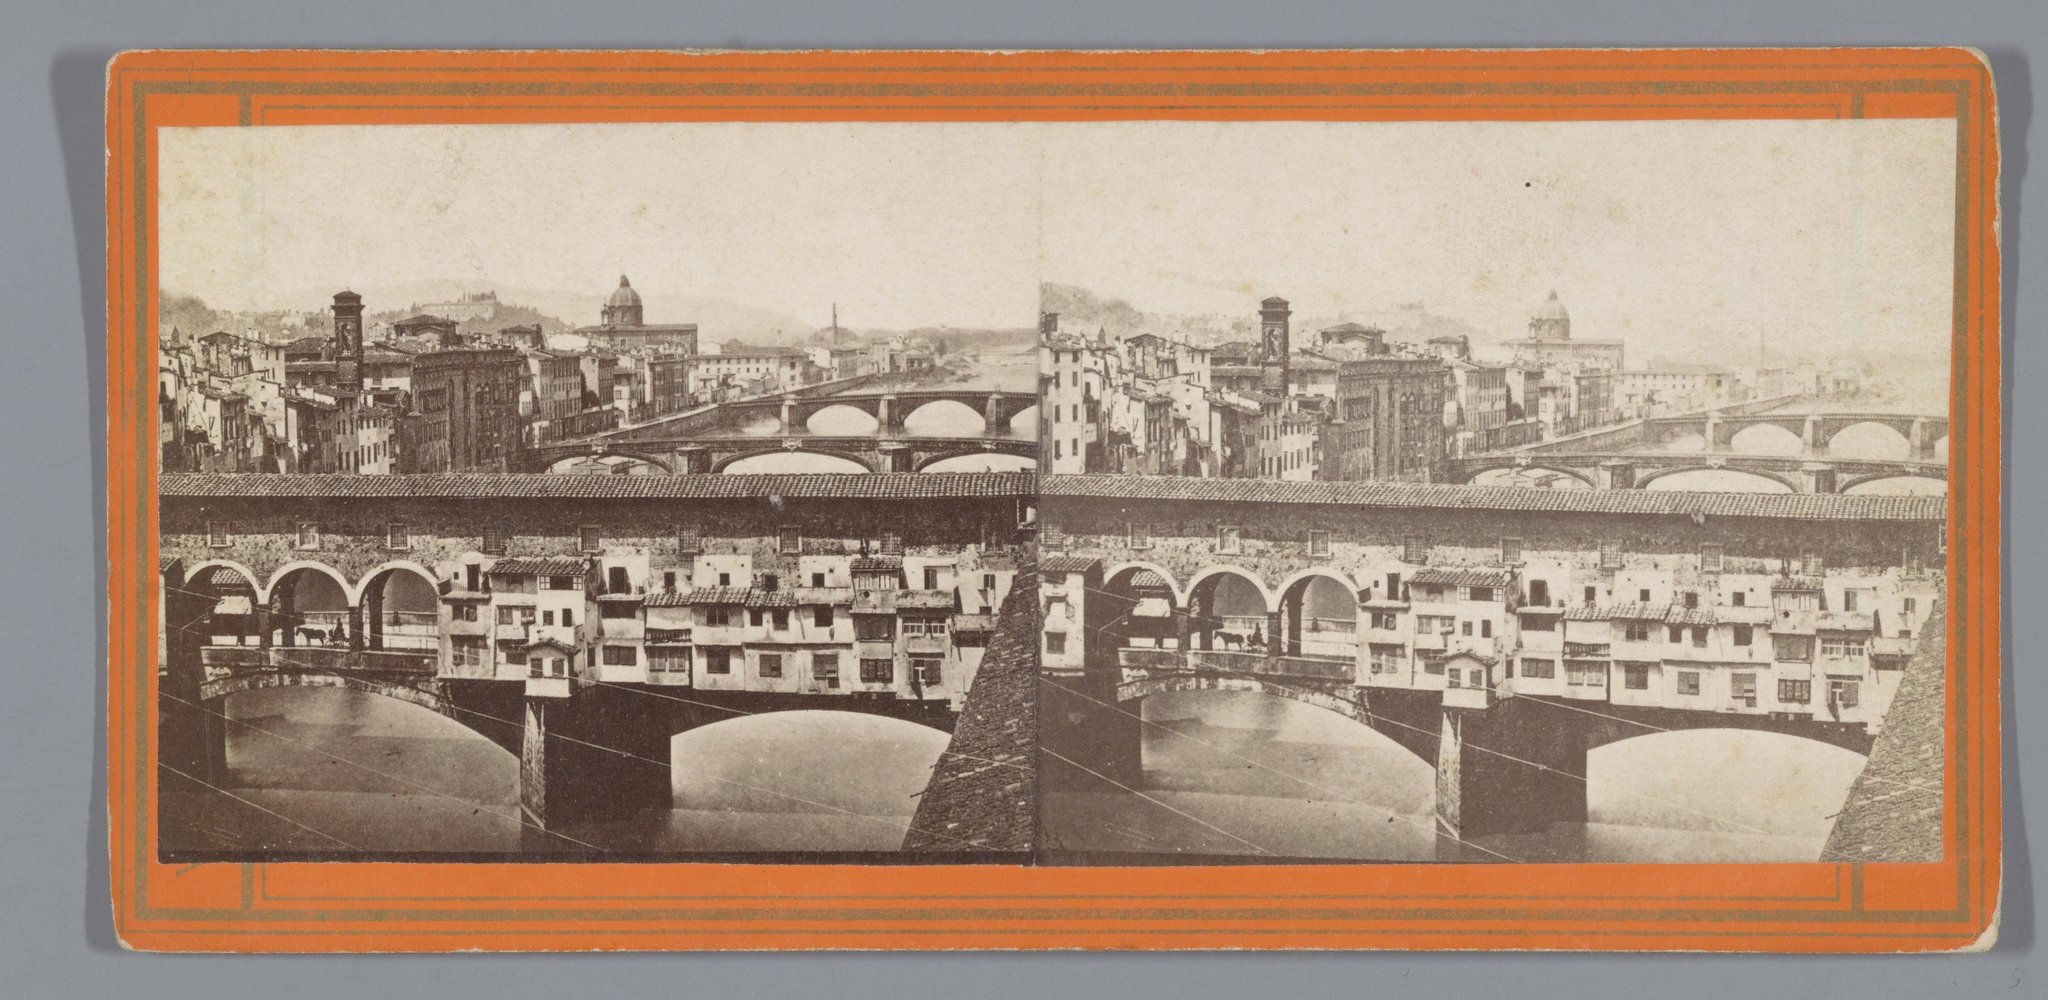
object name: stereograph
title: Gezicht op de Ponte Vecchio te Florence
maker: Anonymous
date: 1850-1880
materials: cardboard, photographic support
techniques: albumen print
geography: florence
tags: river, bridge in city with structures, i.e. shops, houses, e.g. ponte vecchio in florence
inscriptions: inscription: ‘Florence’